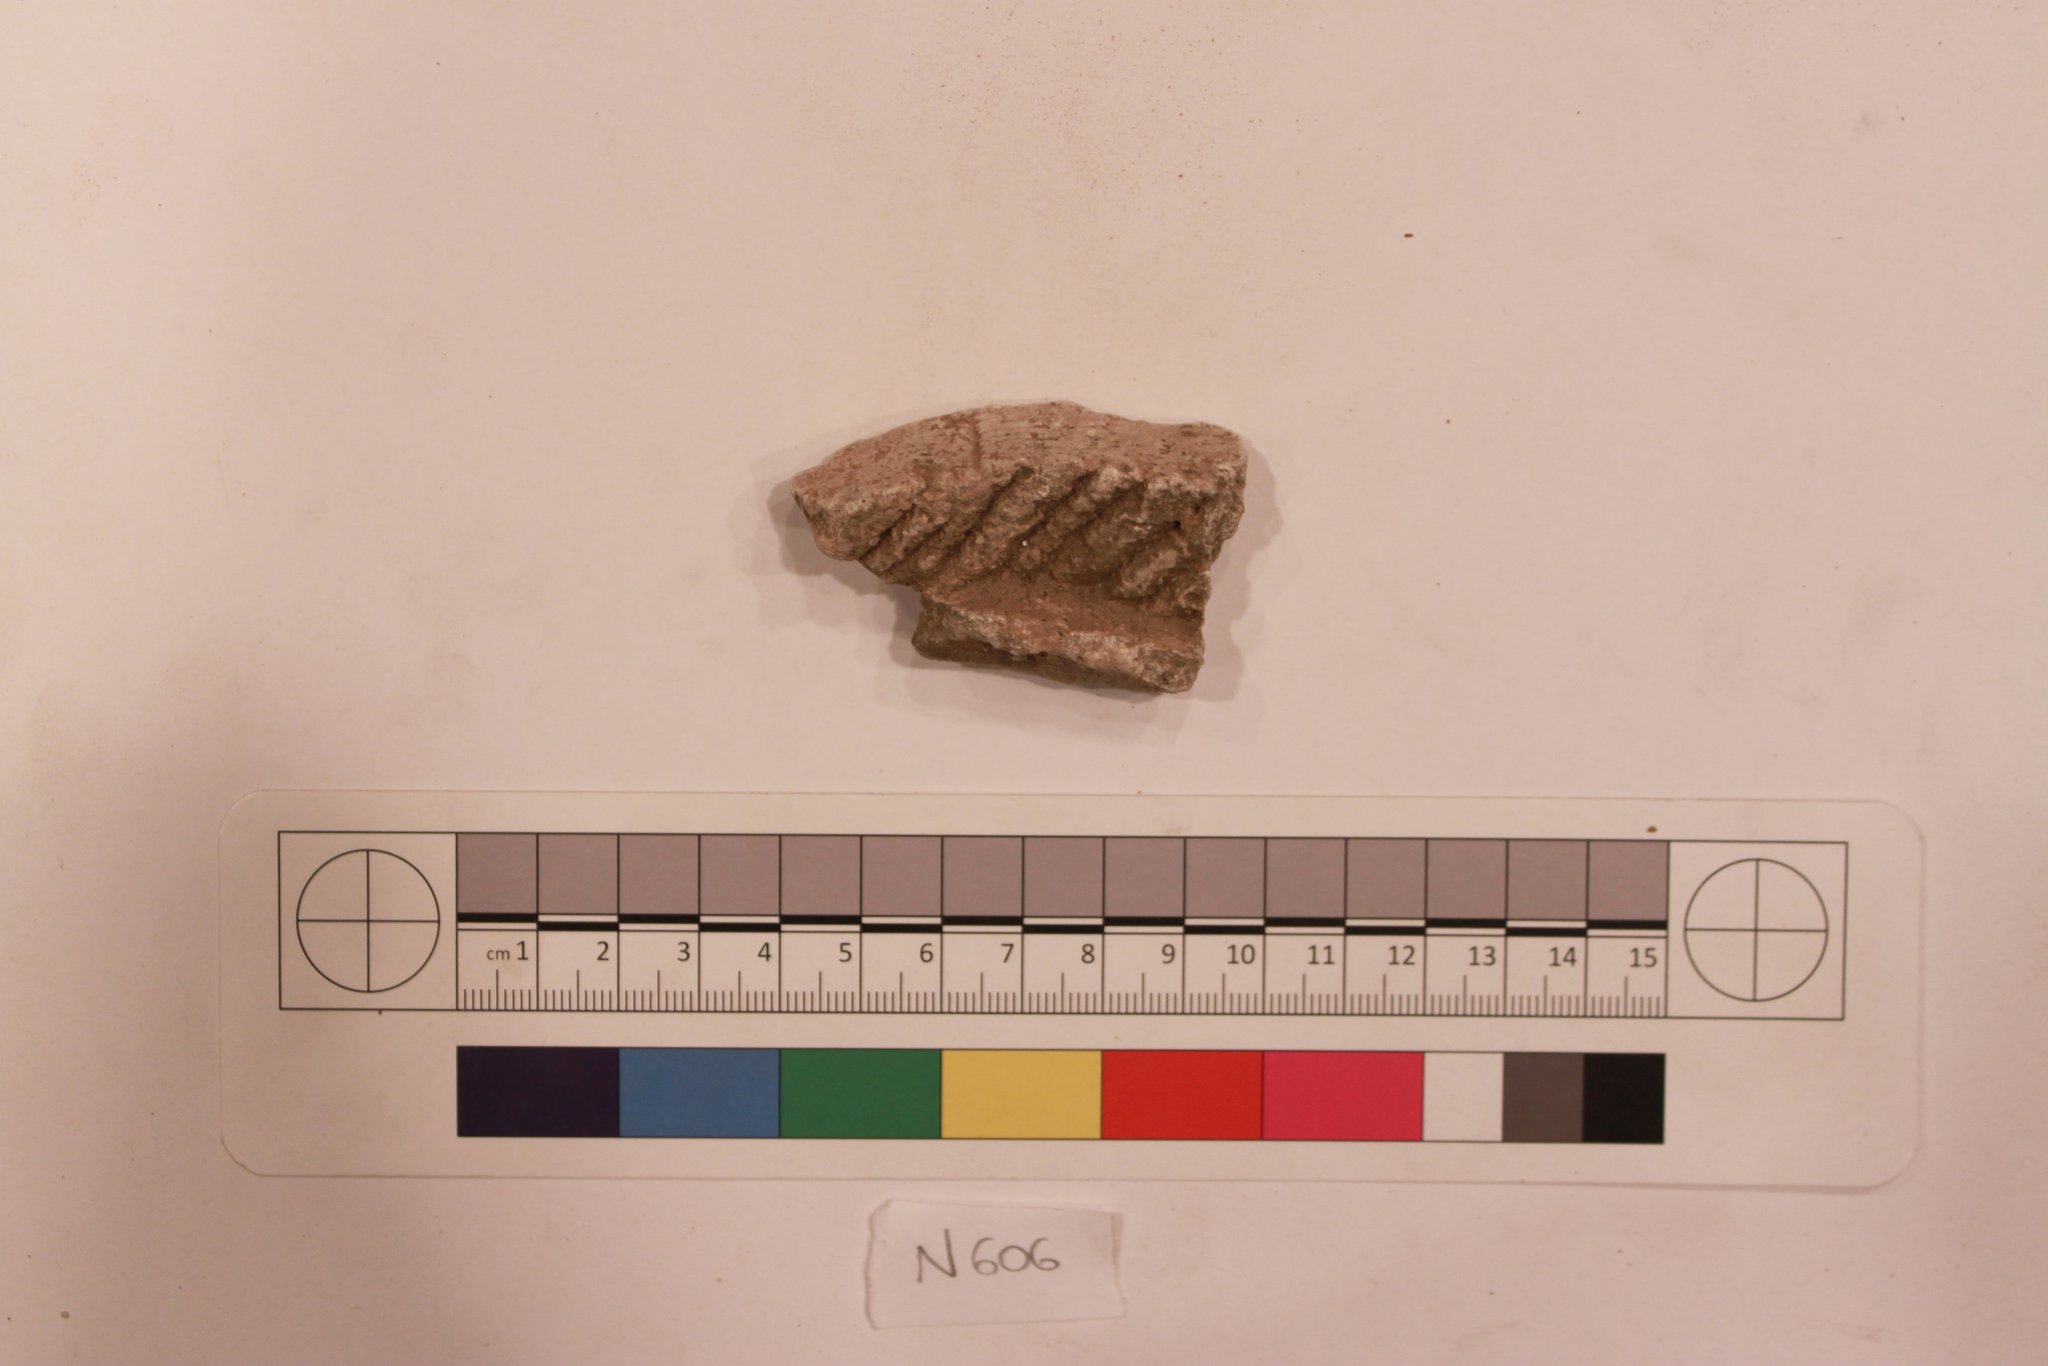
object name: fragment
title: Stucco Fragment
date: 701-1200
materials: plaster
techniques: carving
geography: iran